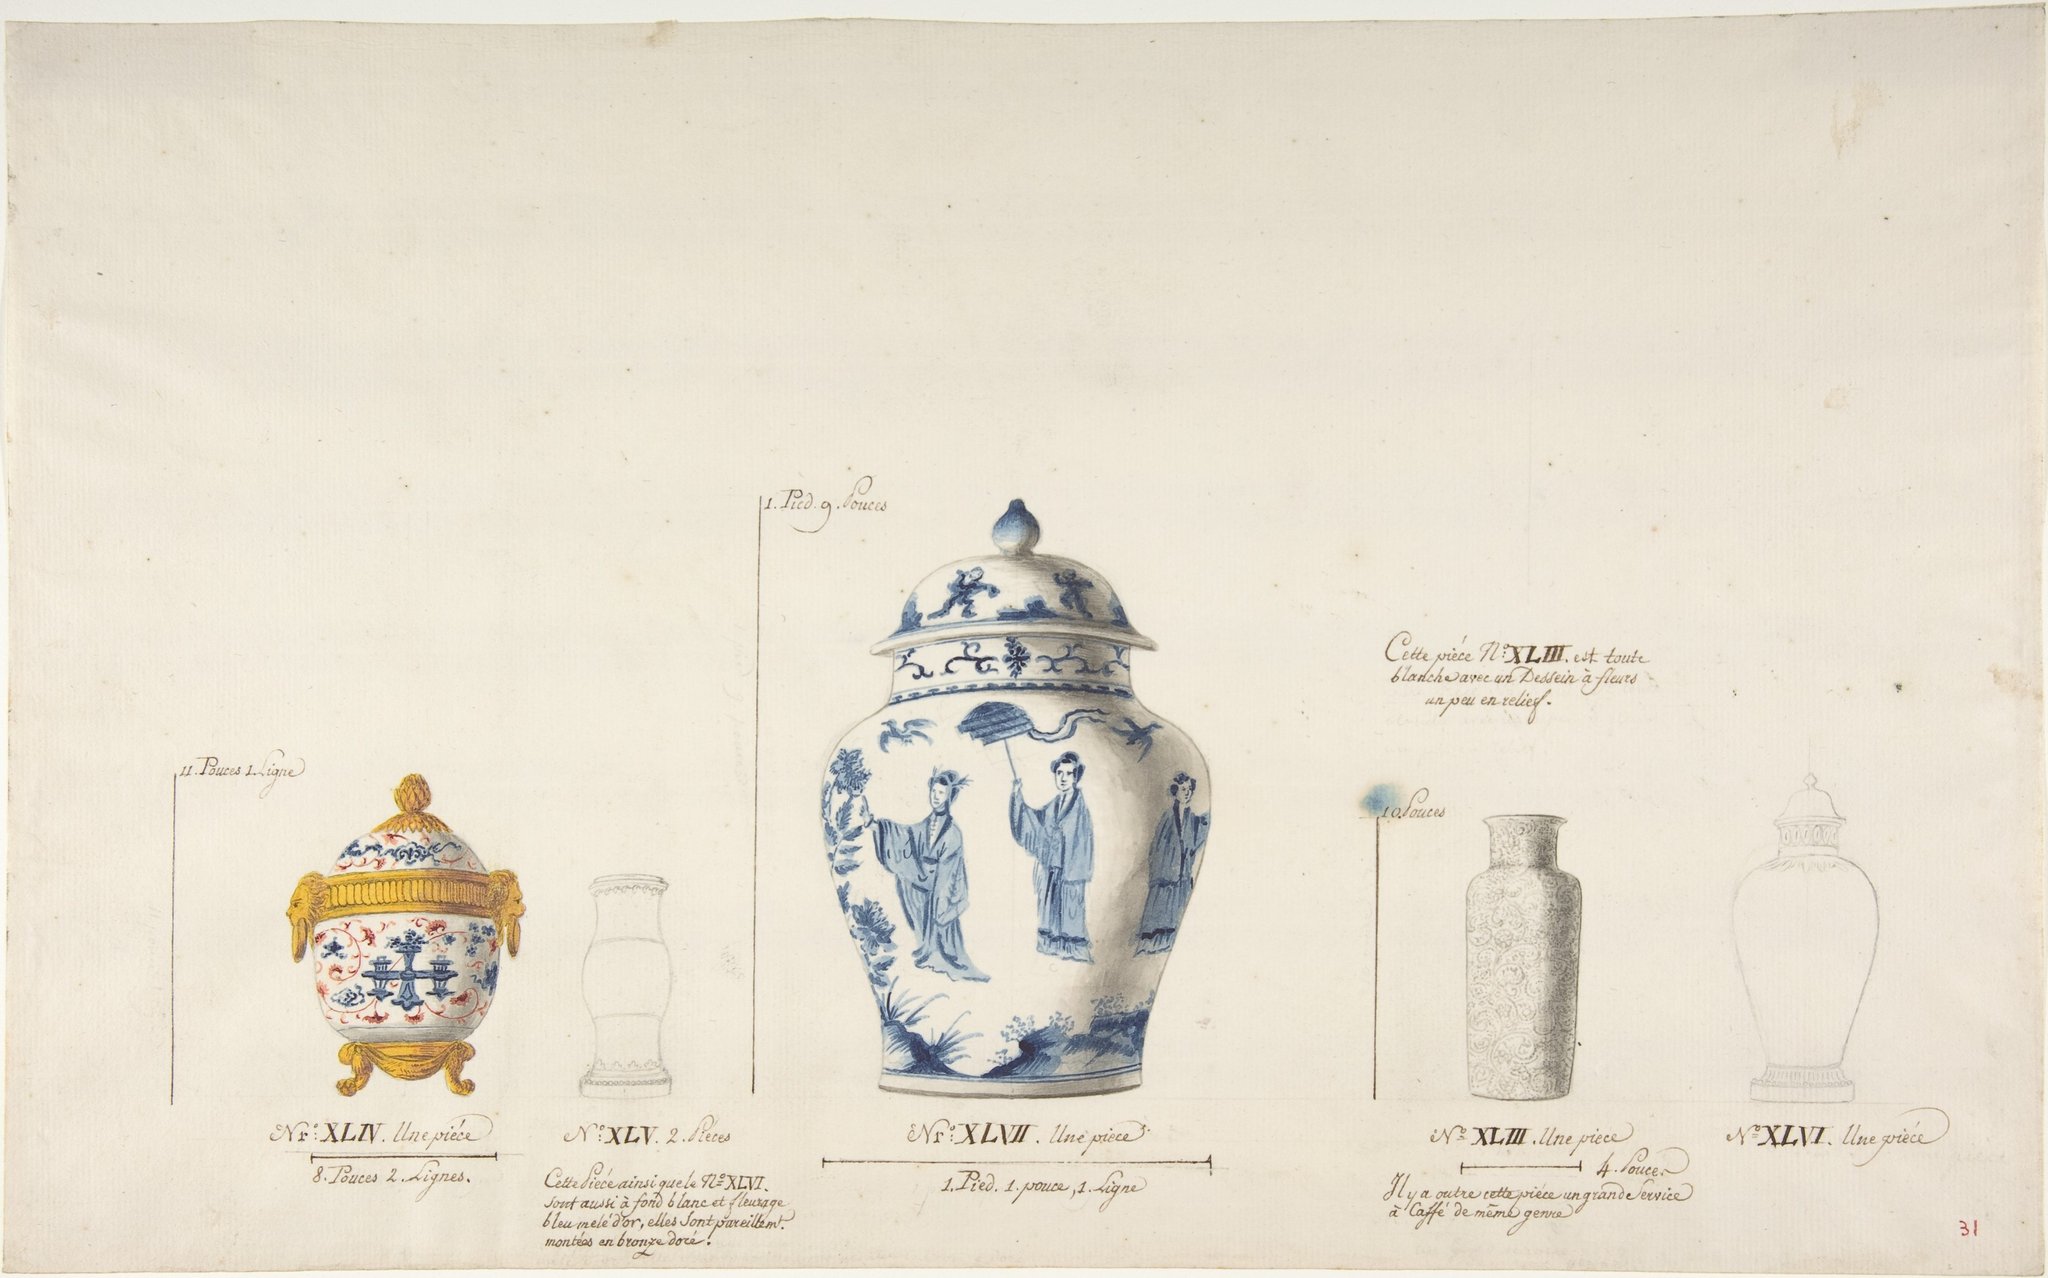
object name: drawing ornament architecture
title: Design for Five Vases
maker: anonymous, french, 18th century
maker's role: artist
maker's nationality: french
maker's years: 1700-1800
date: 1770-1785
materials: chalk, ink, watercolor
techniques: pen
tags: birds,men,vases